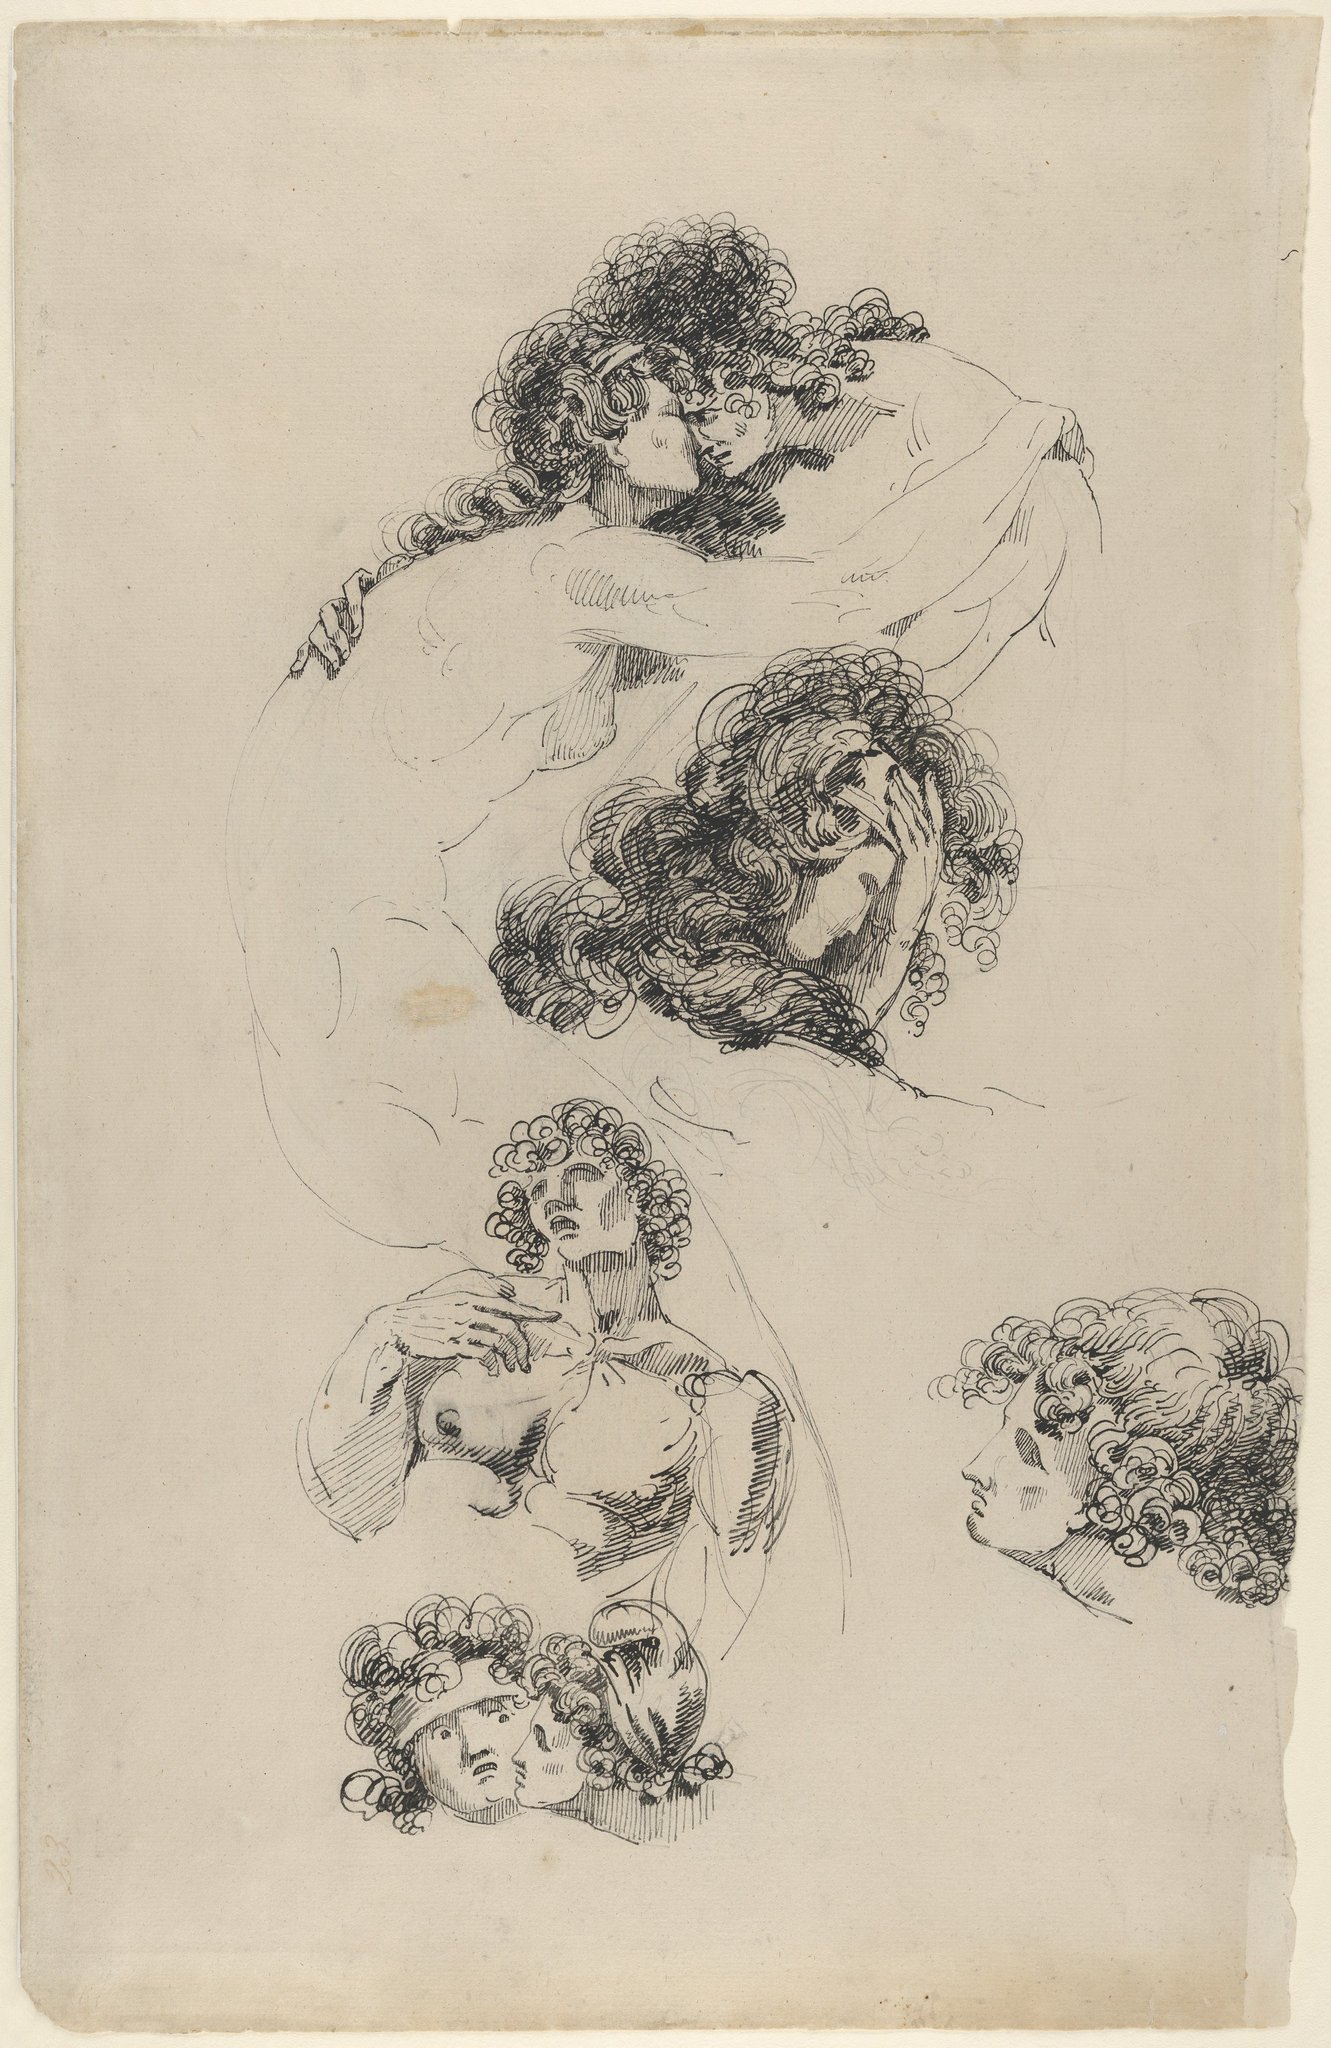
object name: drawing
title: Lovers embracing (recto). A suppliant figure (verso)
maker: james jefferys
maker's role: artist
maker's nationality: british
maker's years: 1751-1784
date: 1779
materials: graphite, ink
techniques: brush, pen, wash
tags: couples,men,lovers,women